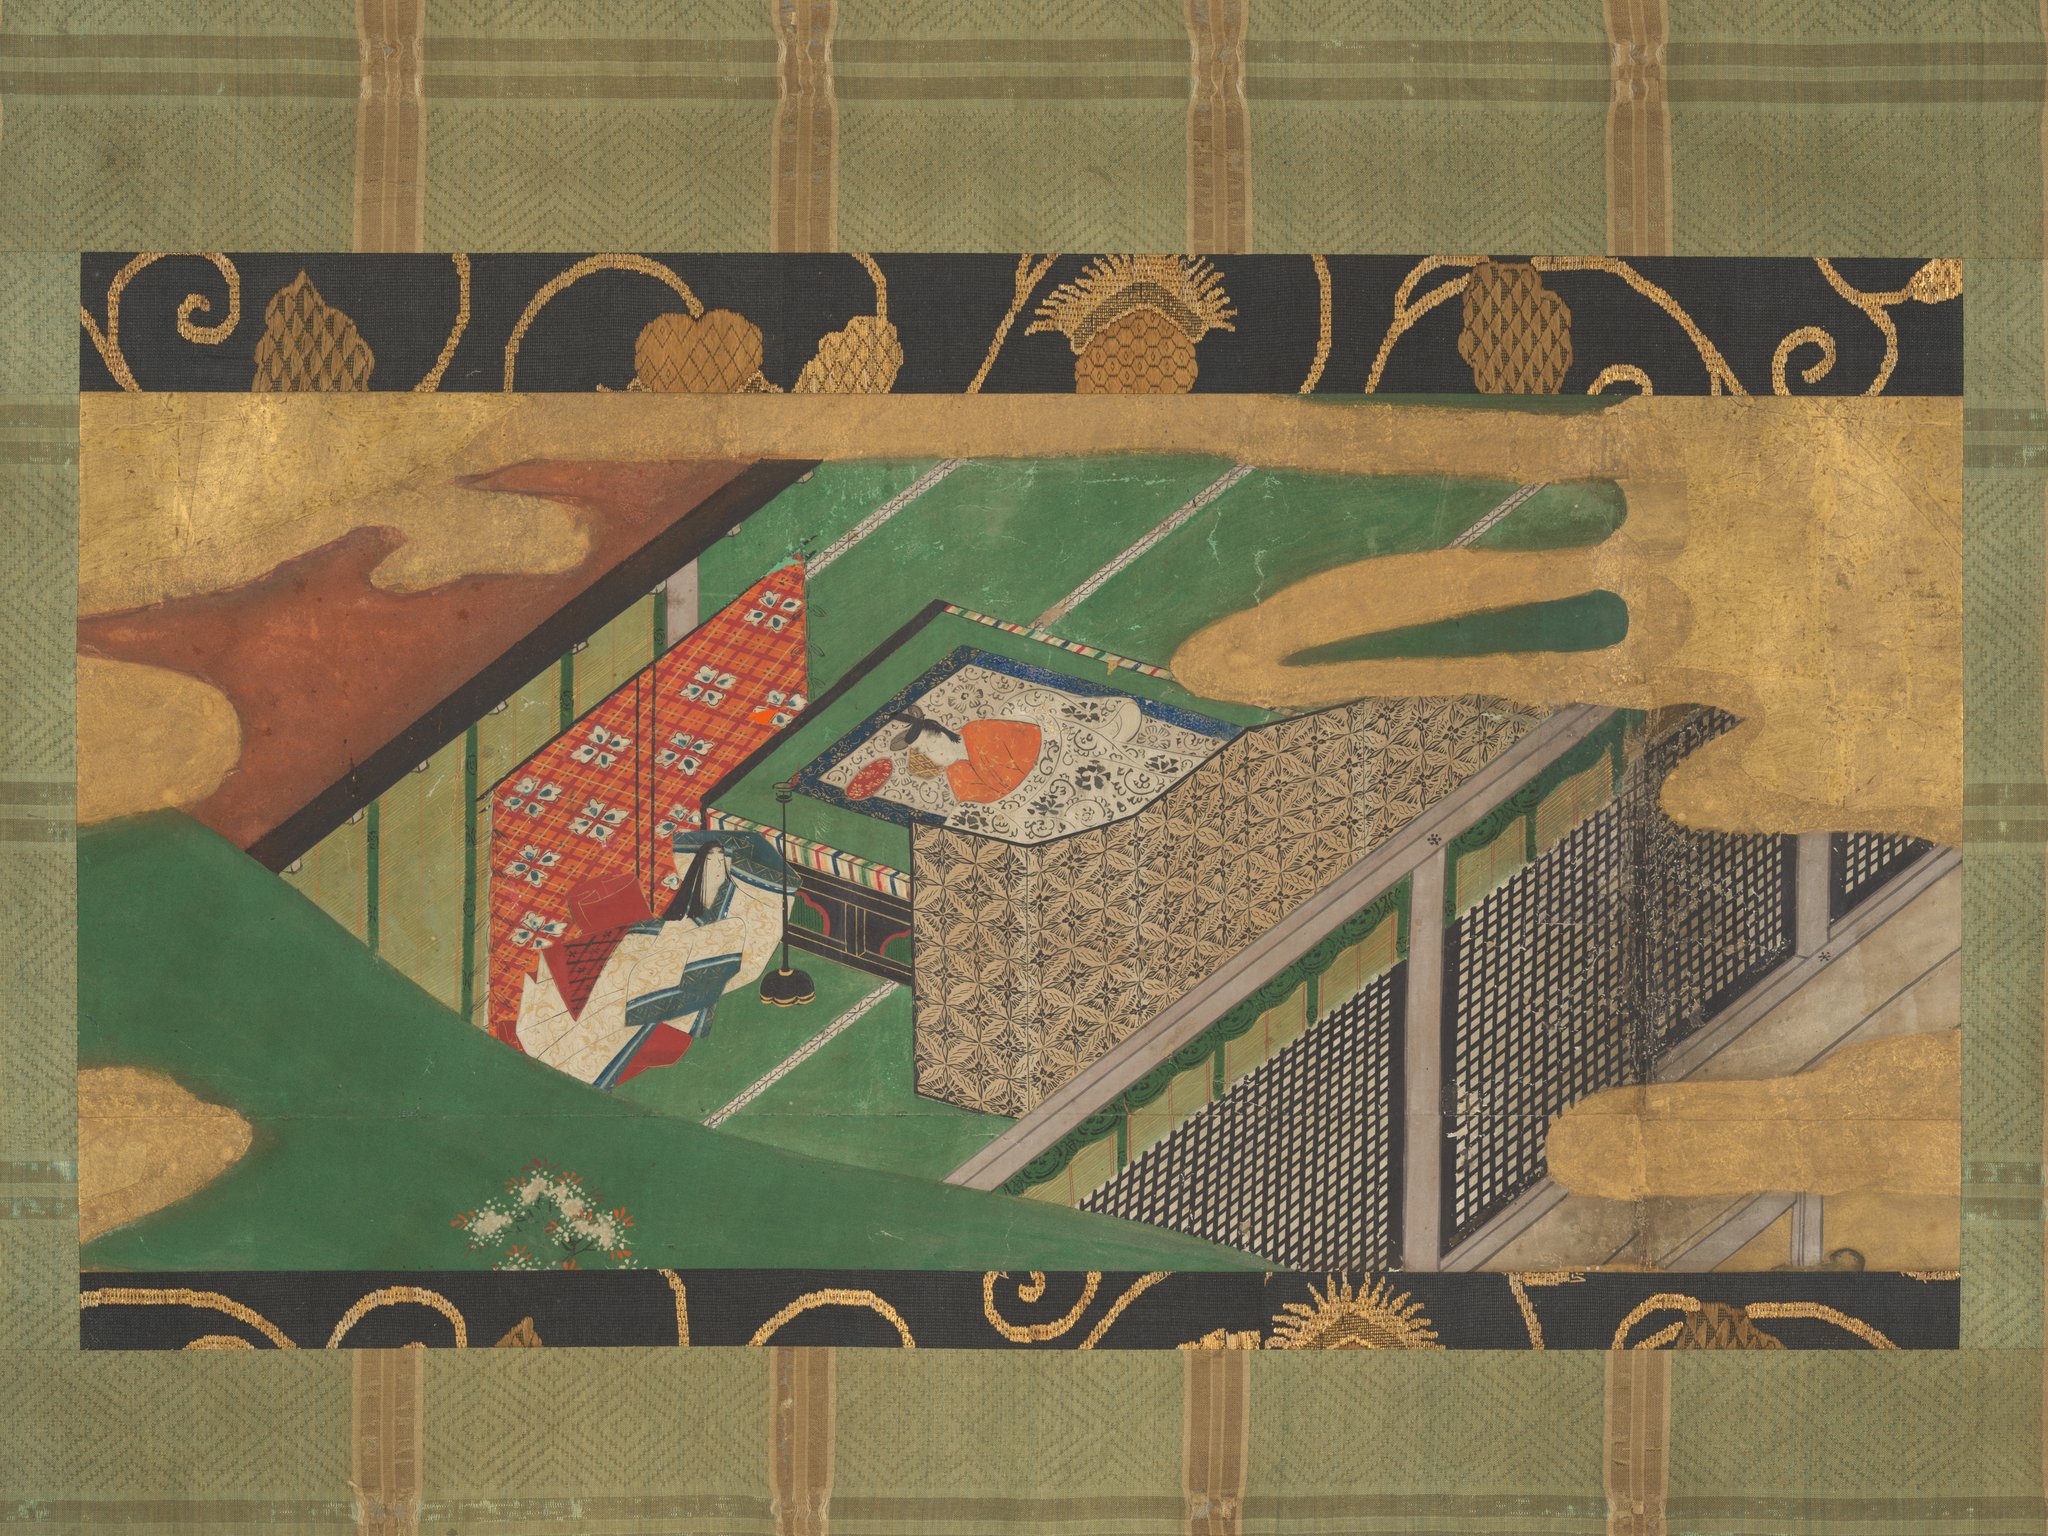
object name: hanging scroll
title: “Trees Encoiled in Vines of Ivy” (Yadorigi)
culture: japanese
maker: tawaraya sōtatsu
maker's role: artist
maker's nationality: japanese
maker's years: 1570-1640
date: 1601-1633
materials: gold, ink, paper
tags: sleeping,men,women,beds